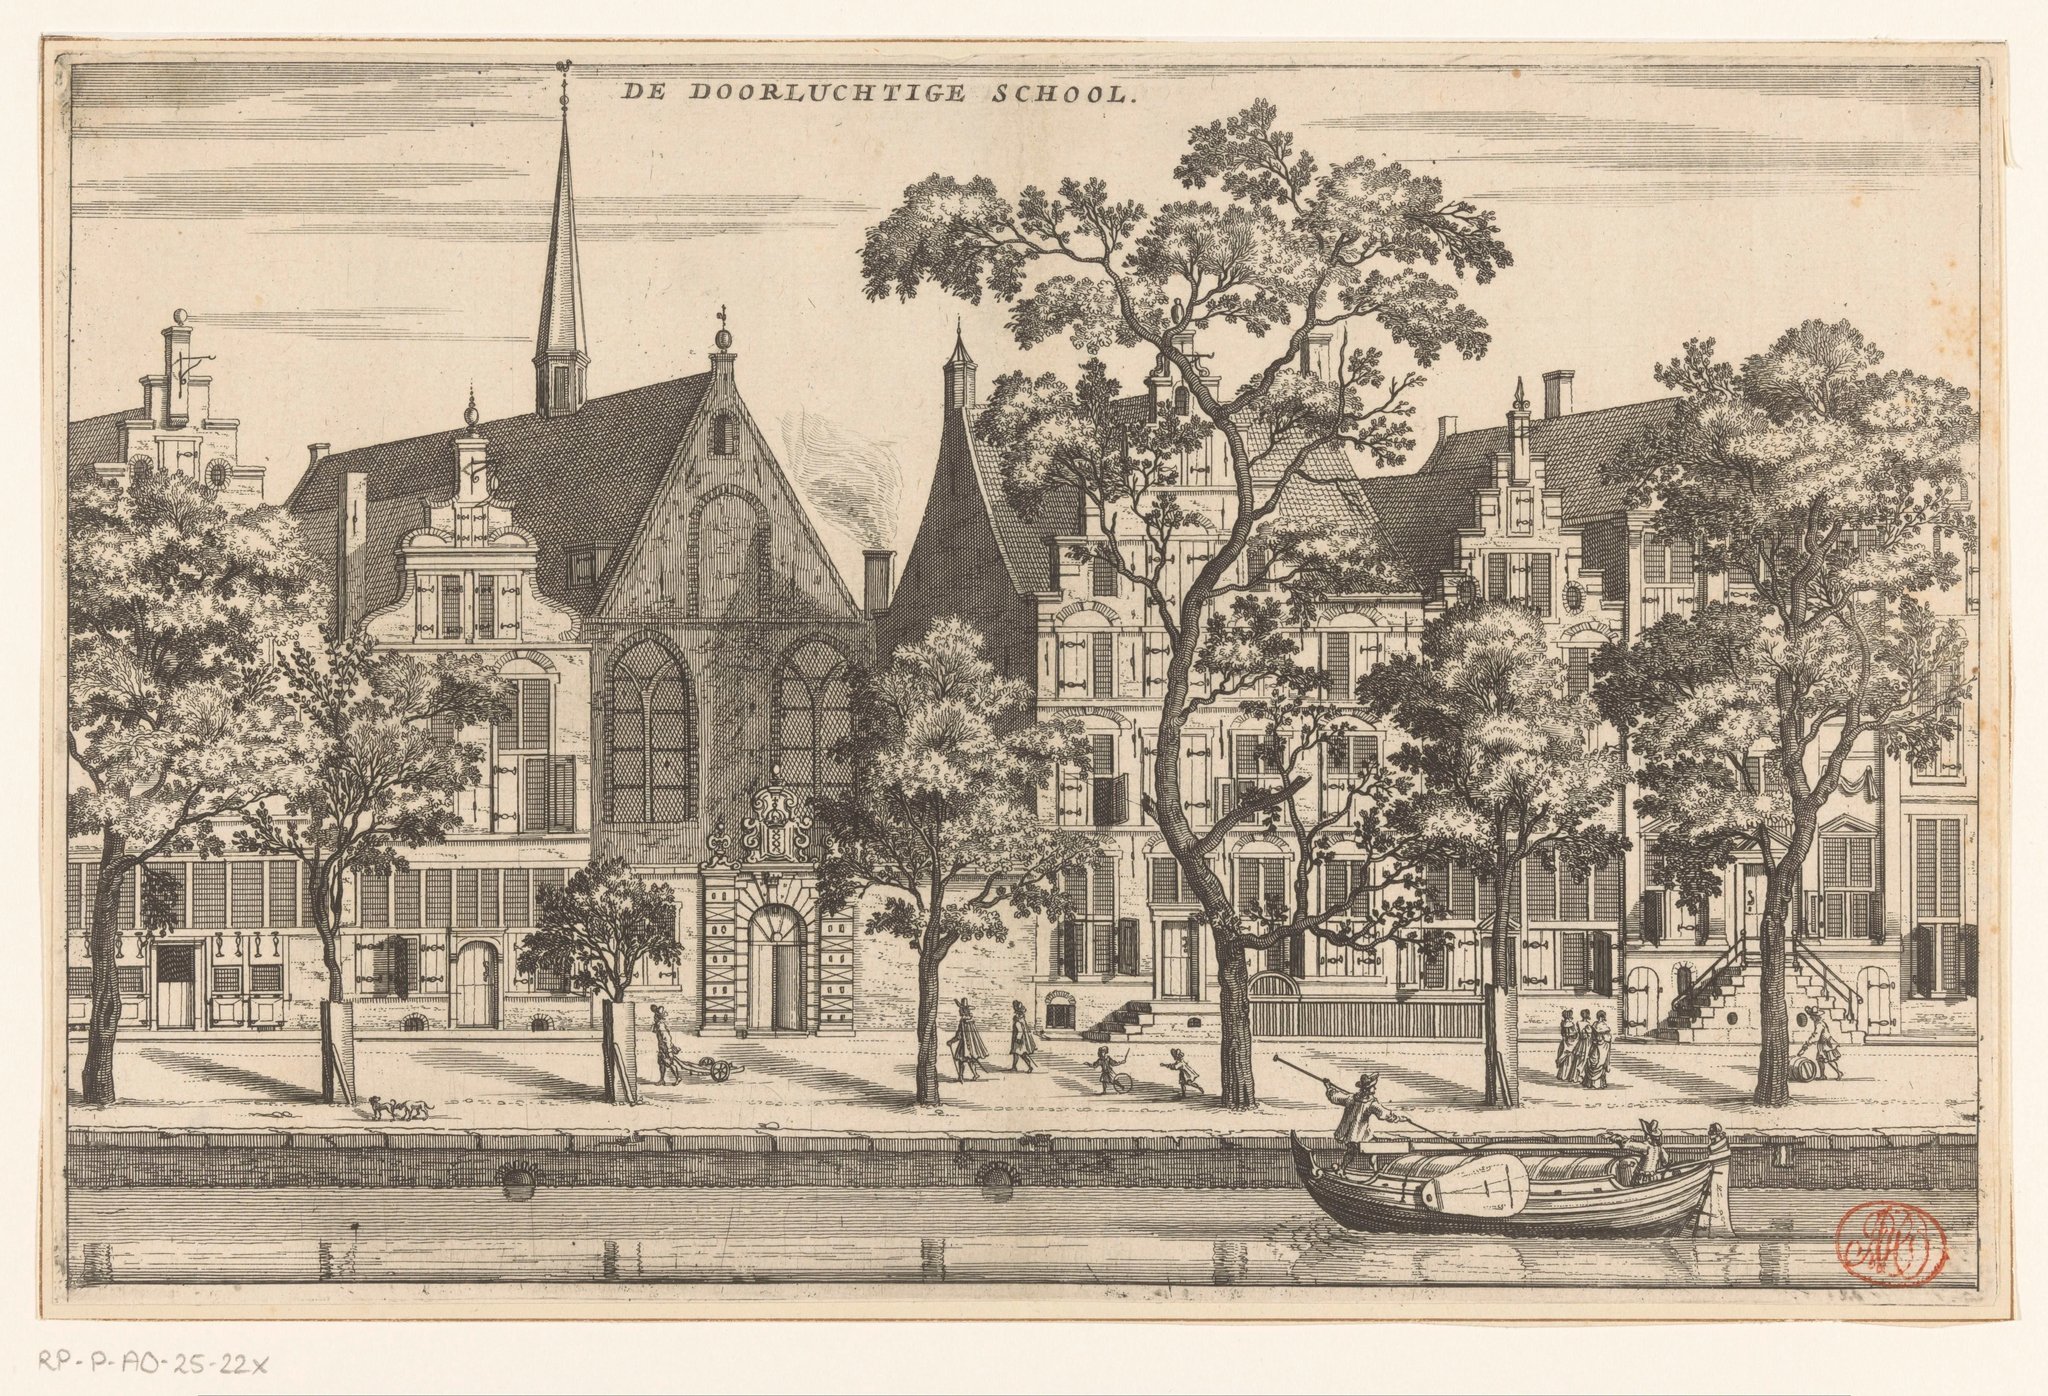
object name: print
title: De Doorluchtige School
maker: jacob van meurs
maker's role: draughtsman, print maker, publisher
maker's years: 1619-1680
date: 1663-1664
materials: paper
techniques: etching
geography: amsterdam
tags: gate, entrance, university building, college, street (+ city(-scape) with figures, staffage)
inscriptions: collector's mark: Lugt 195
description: Huidige staat van prent ook gebruikt in: Dapper, Olfert. Historische beschryving der stadt Amsterdam: waer in de voornaemste geschiedenissen (na een kort verhael van gansch Hollant en d'omleggende dorpen (…). Amsterdam: Jacob van Meurs, 1663.* En in: Zesen, Philipp von. Beschreibung der Stadt Amsterdam: darinnen von derselben ersten Ursprunge bis auf gegenwärtigen Zustand (…). Amsterdam: Joachim Nosche, 1664. * In sommige exemplaren van deze uitgave komt de huidige staat van de prent voor. In andere exemplaren is een latere staat ingebonden, waarop boven de Nederlandse een Franse titel is toegevoegd.